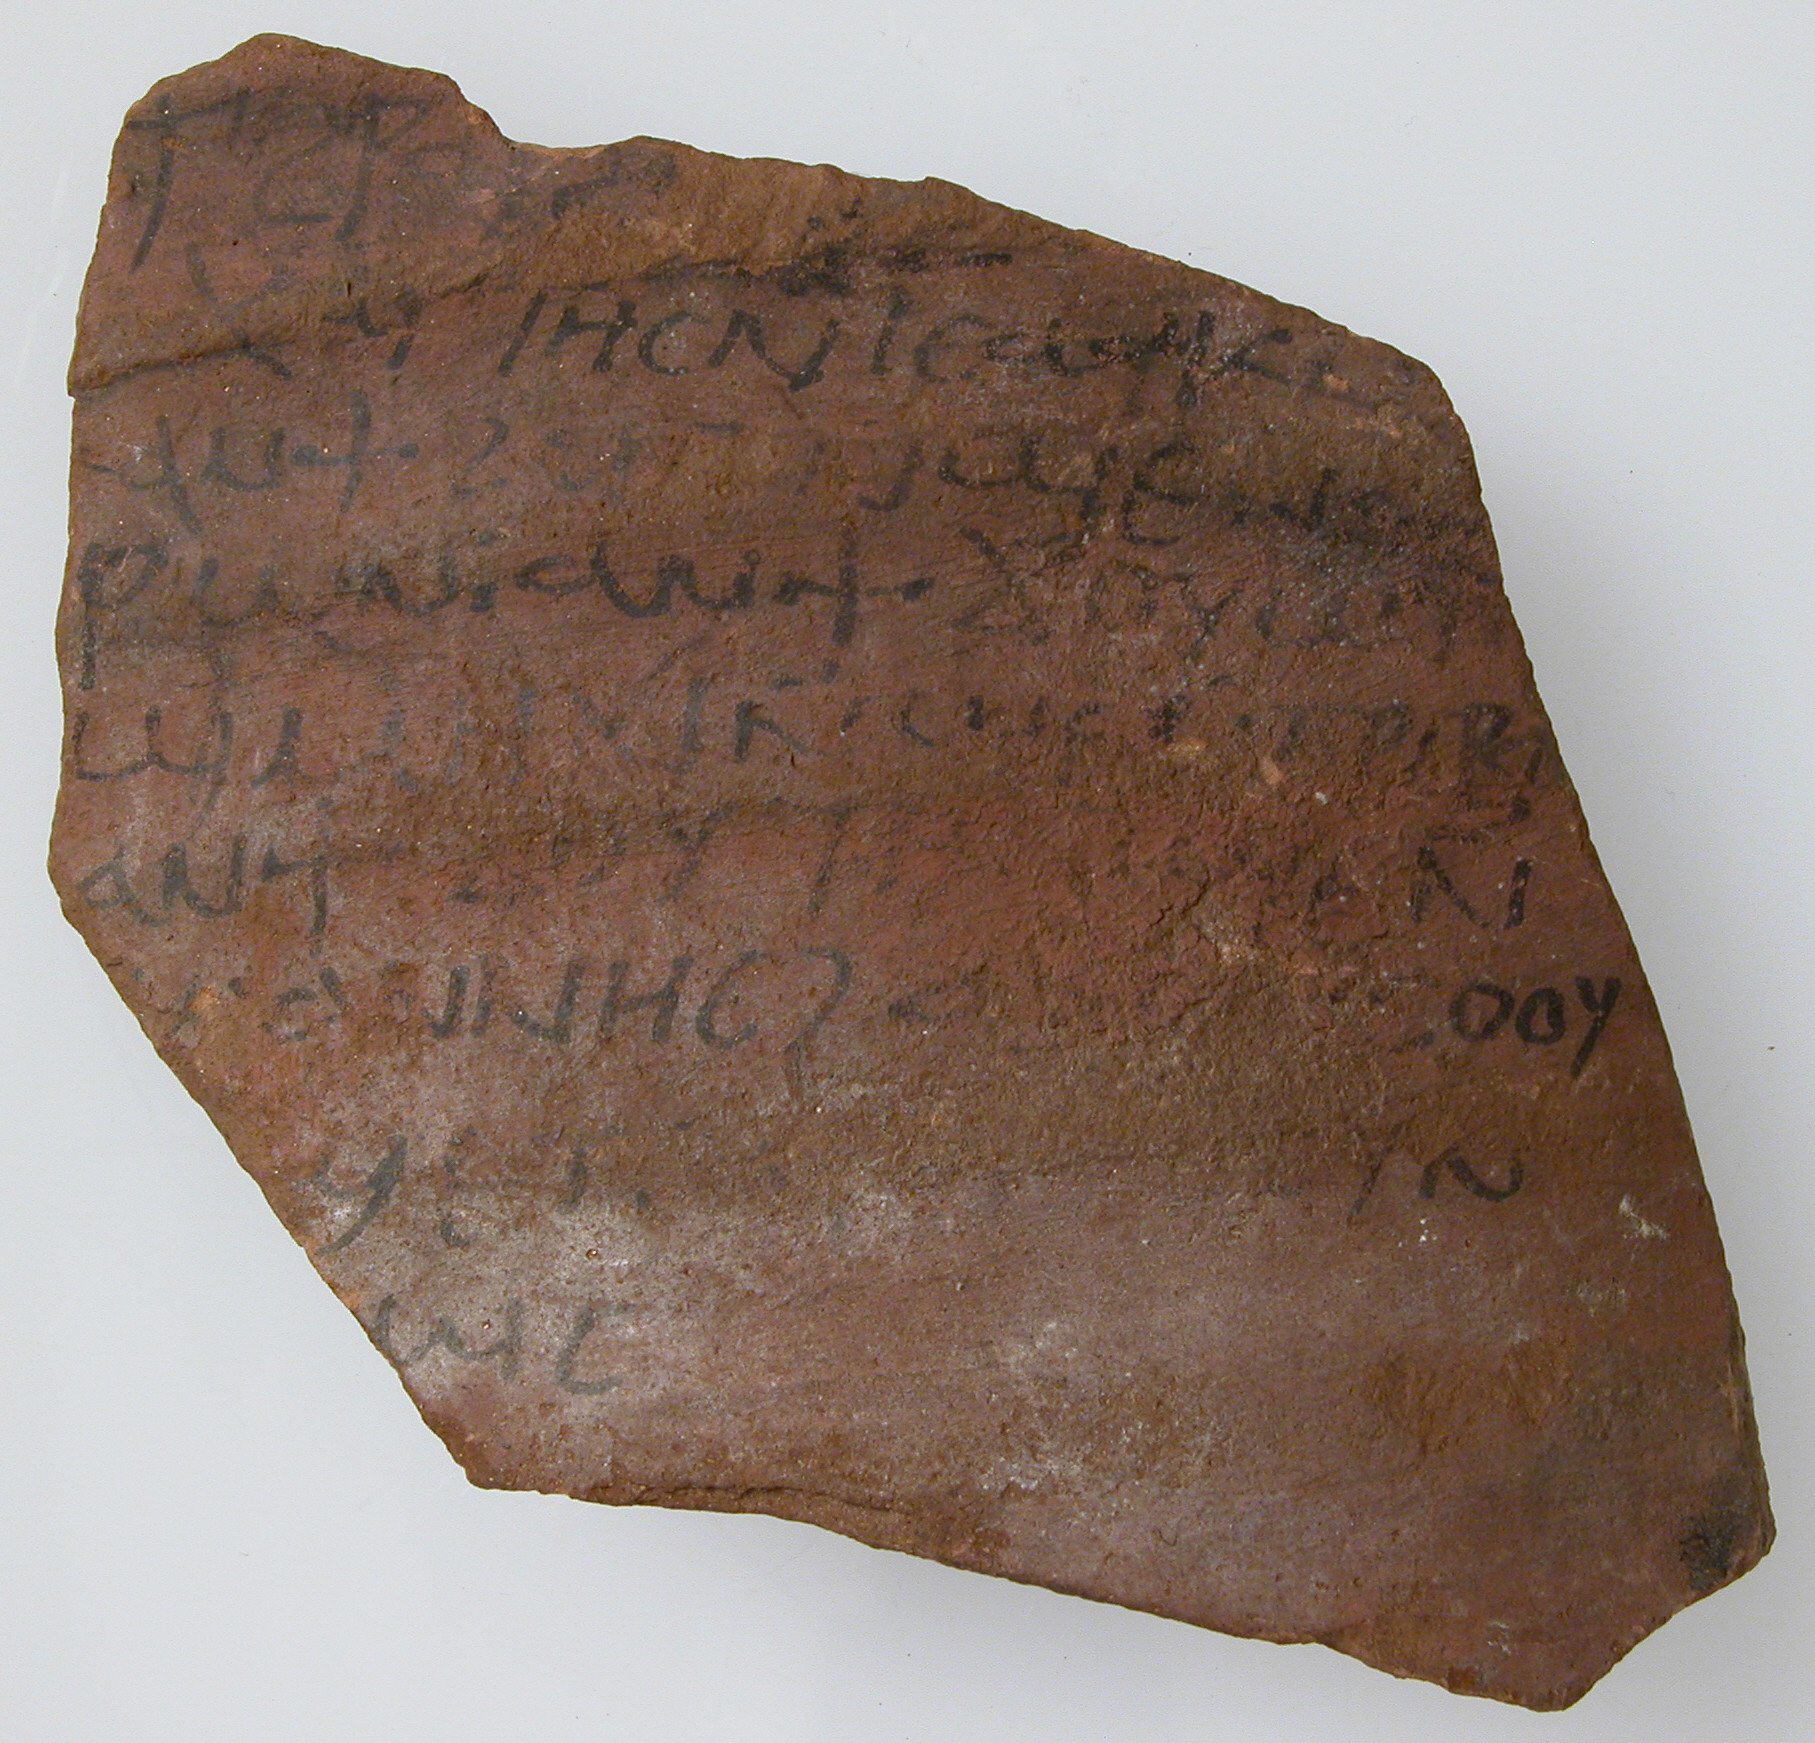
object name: ostrakon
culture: coptic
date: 601-700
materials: ink, pottery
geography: egypt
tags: documents